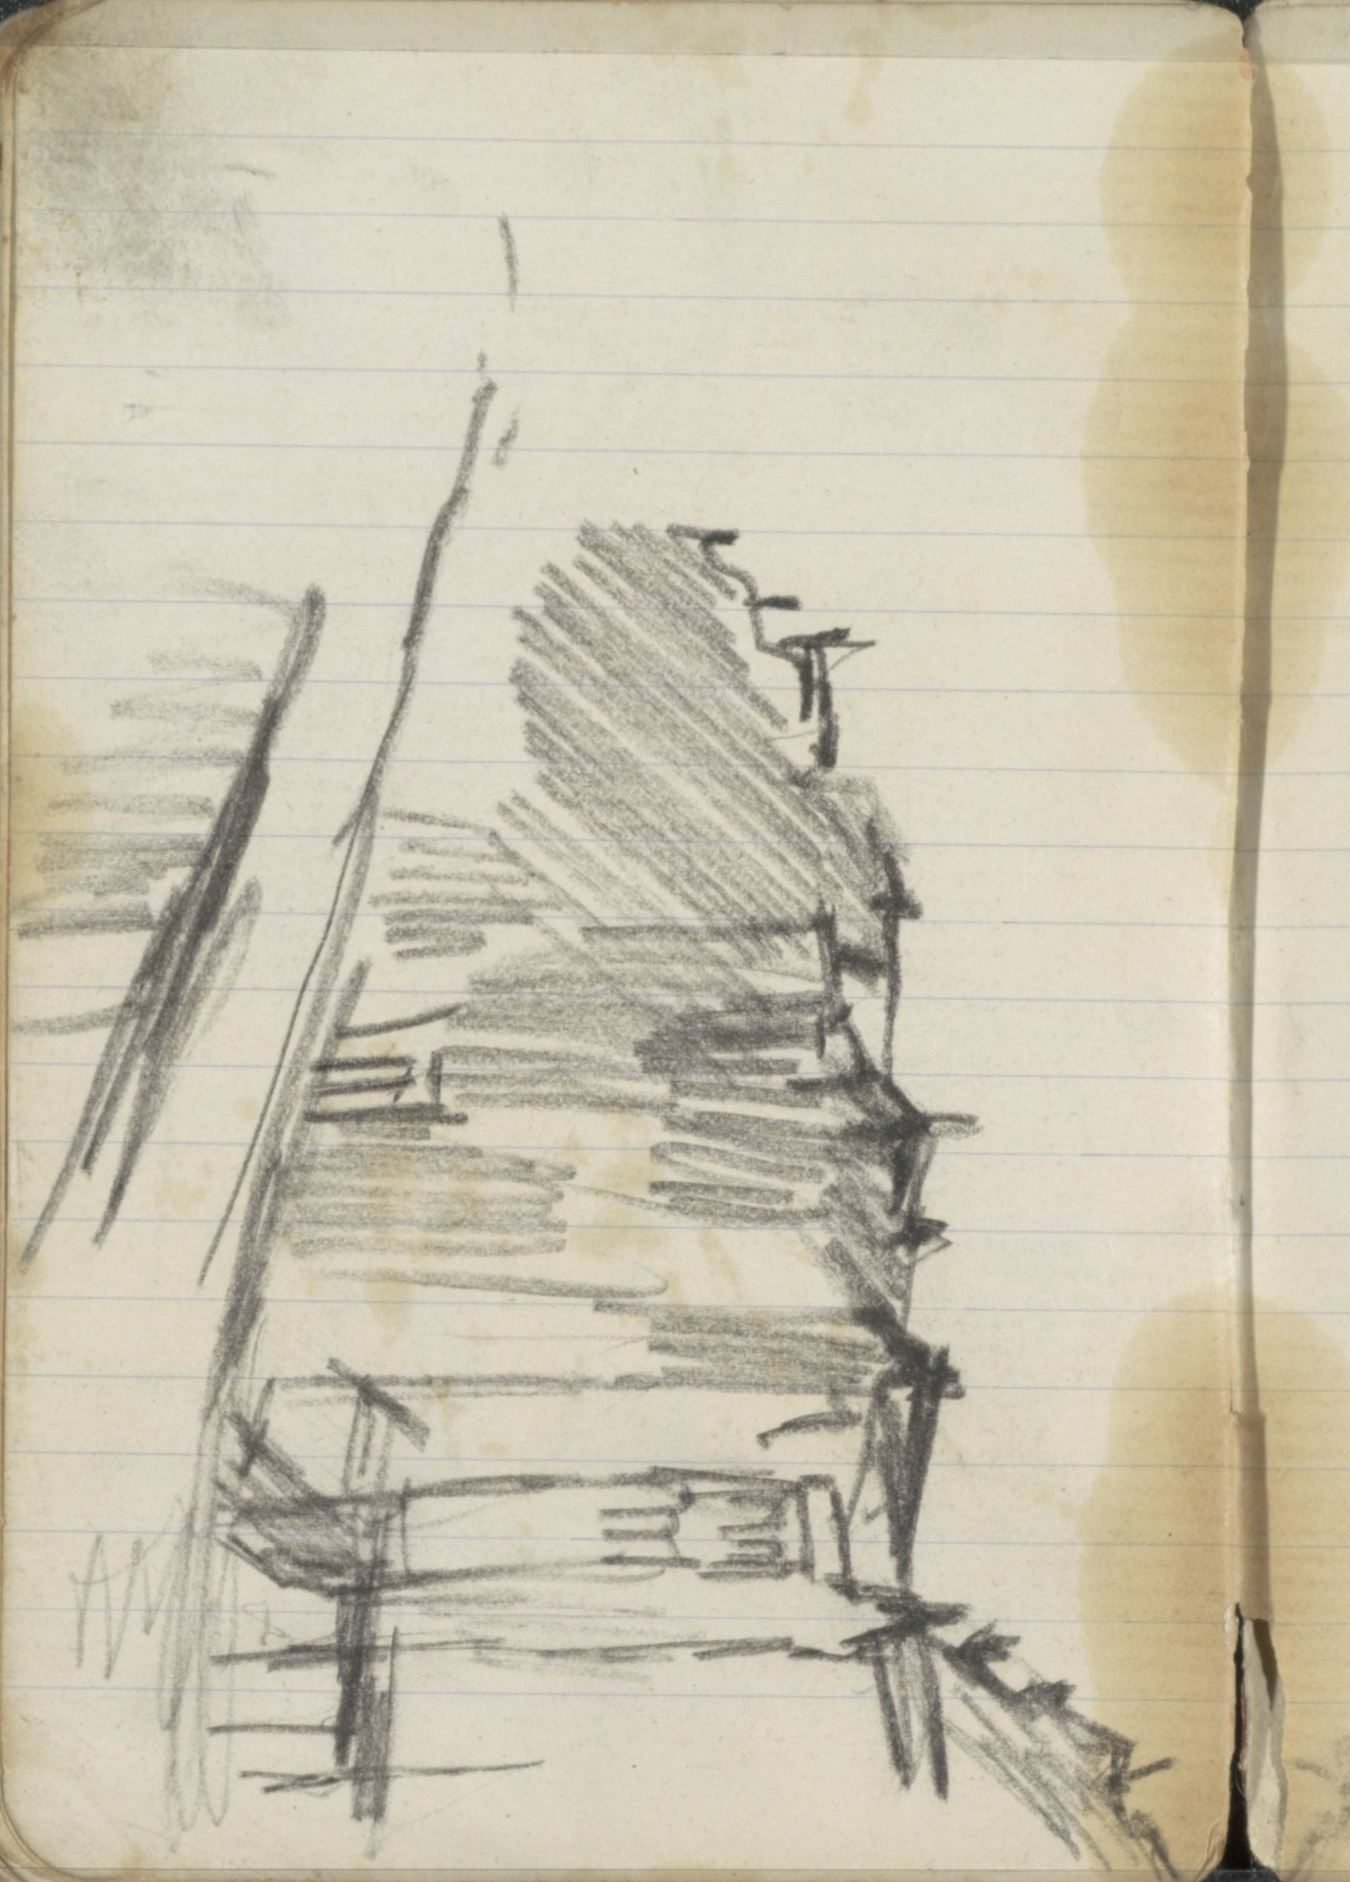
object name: sketchbook leaf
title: Gezicht op het Rokin te Amsterdam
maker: george hendrik breitner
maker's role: draughtsman, painter, print maker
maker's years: 1857-1923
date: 1896-1901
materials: chalk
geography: amsterdam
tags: canals, waters (in city), civic architecture; edifices; dwellings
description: Mogelijk met kunstenaarsvereniging Arti et Amicitiae (Rokin 112). Pagina 71 uit een schetsboek met 37 bladen.